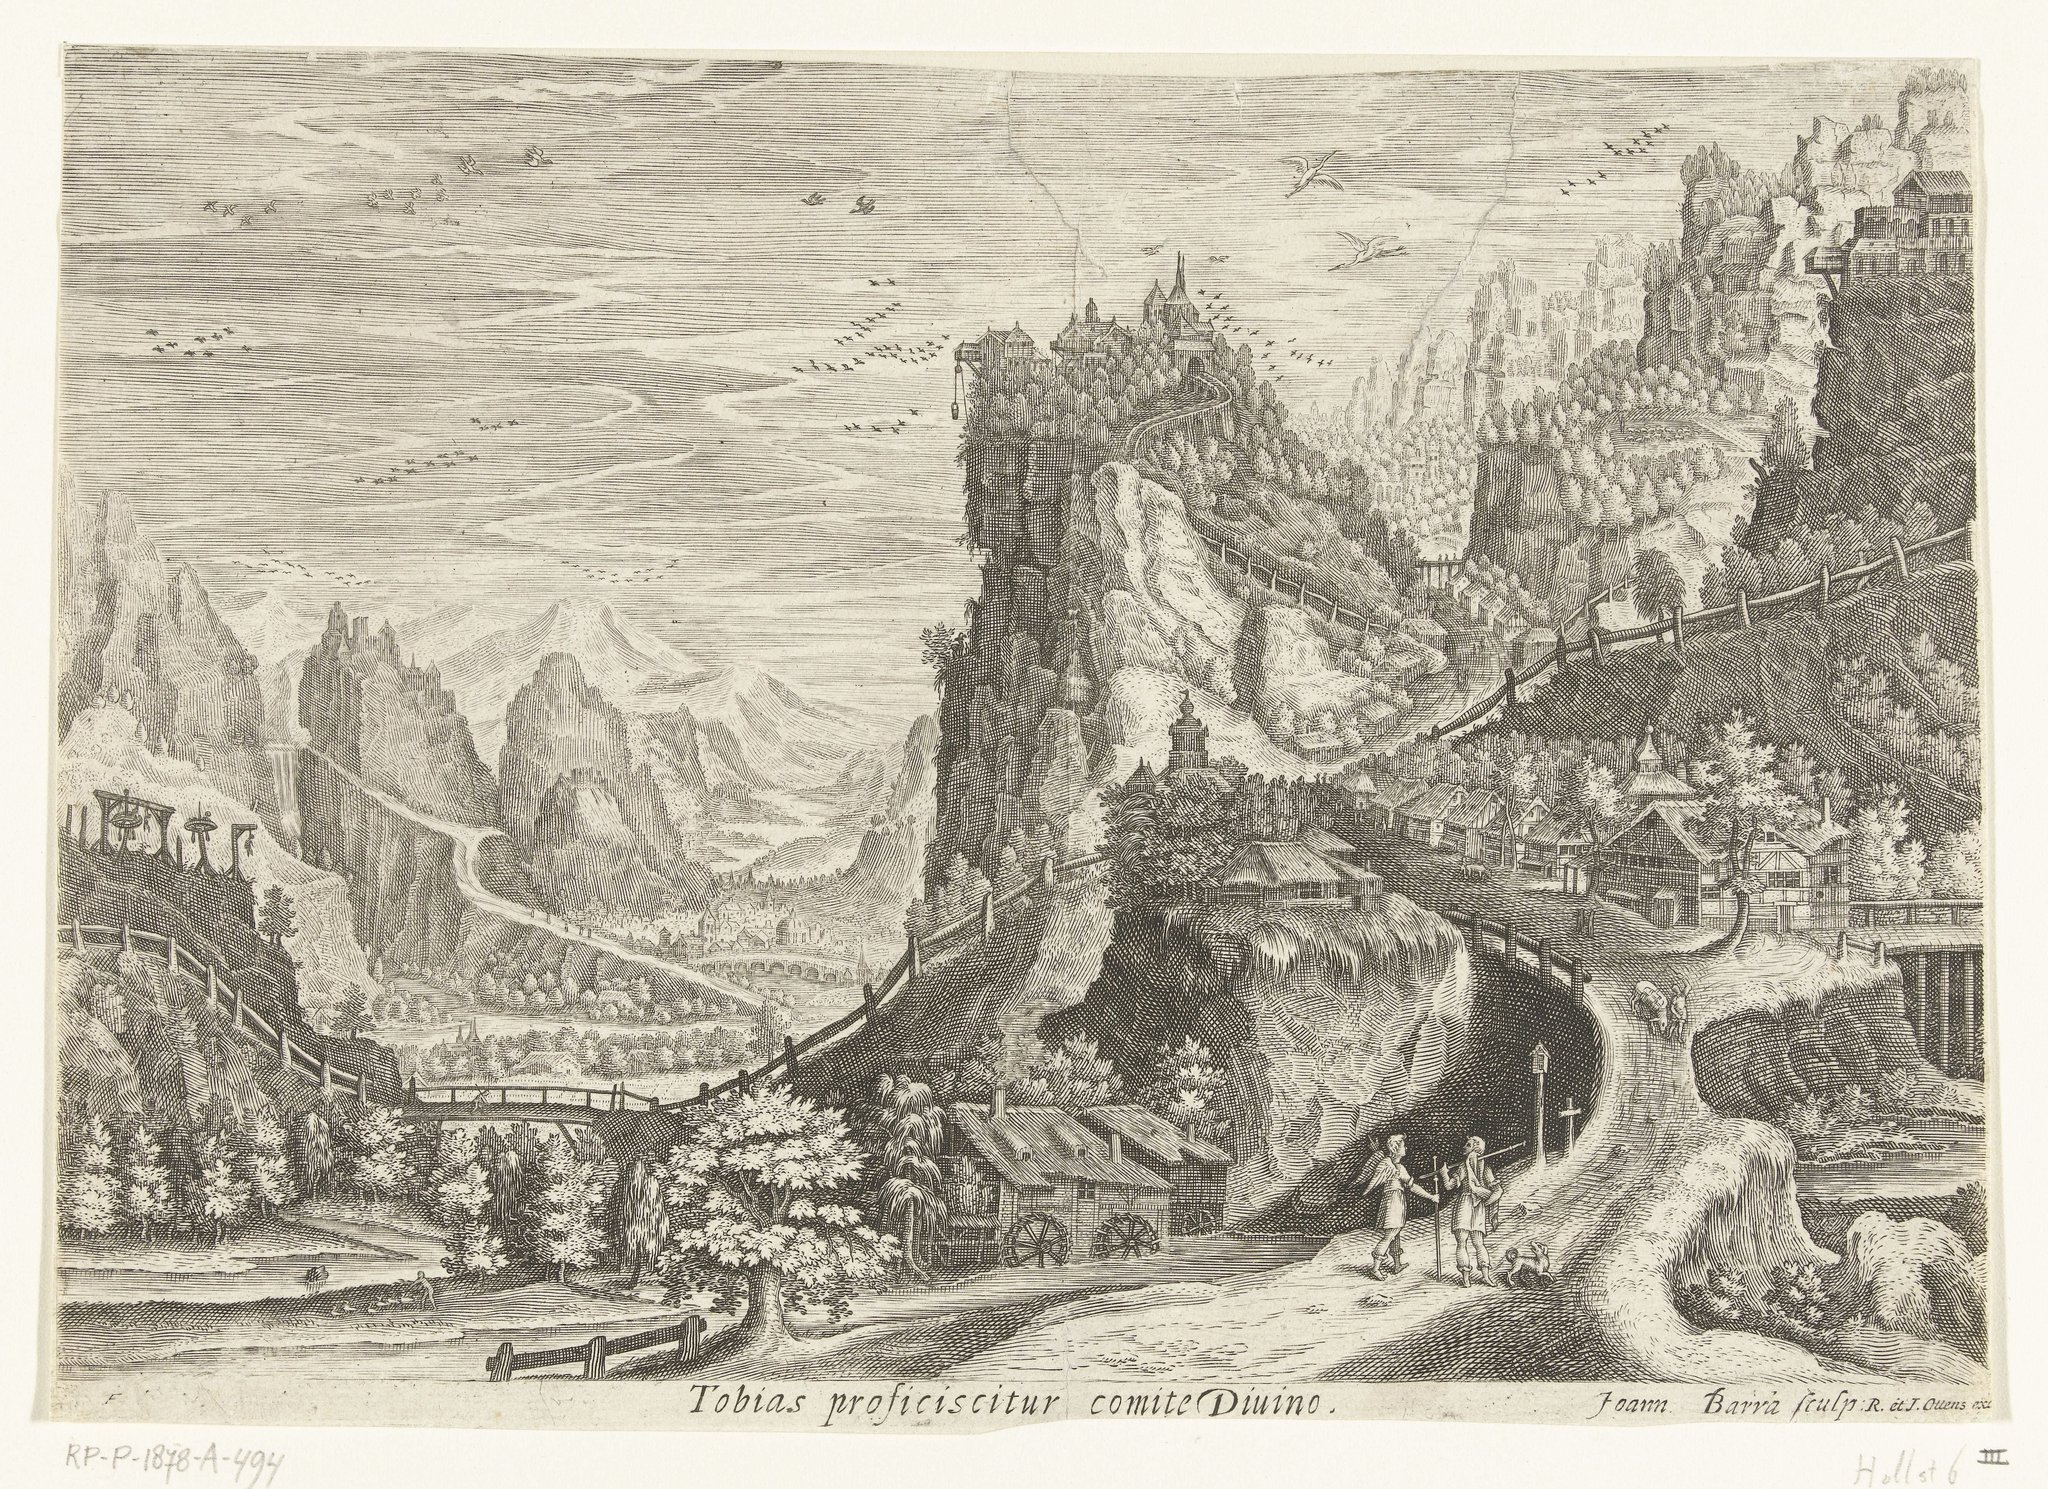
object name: print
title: Tobias proficiscitur comite Divino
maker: johan barra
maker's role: print maker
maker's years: 1581-1634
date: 1591-1634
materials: paper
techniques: engraving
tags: tobias and the angel raphael travelling, accompanied by tobias' dog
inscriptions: collector's mark: Lugt 2228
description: Prent naar ontwerp van Giovanni Domenico Zapponi. Prent maakt deel uit van serie met vier prenten over het verhaal van Tobias.